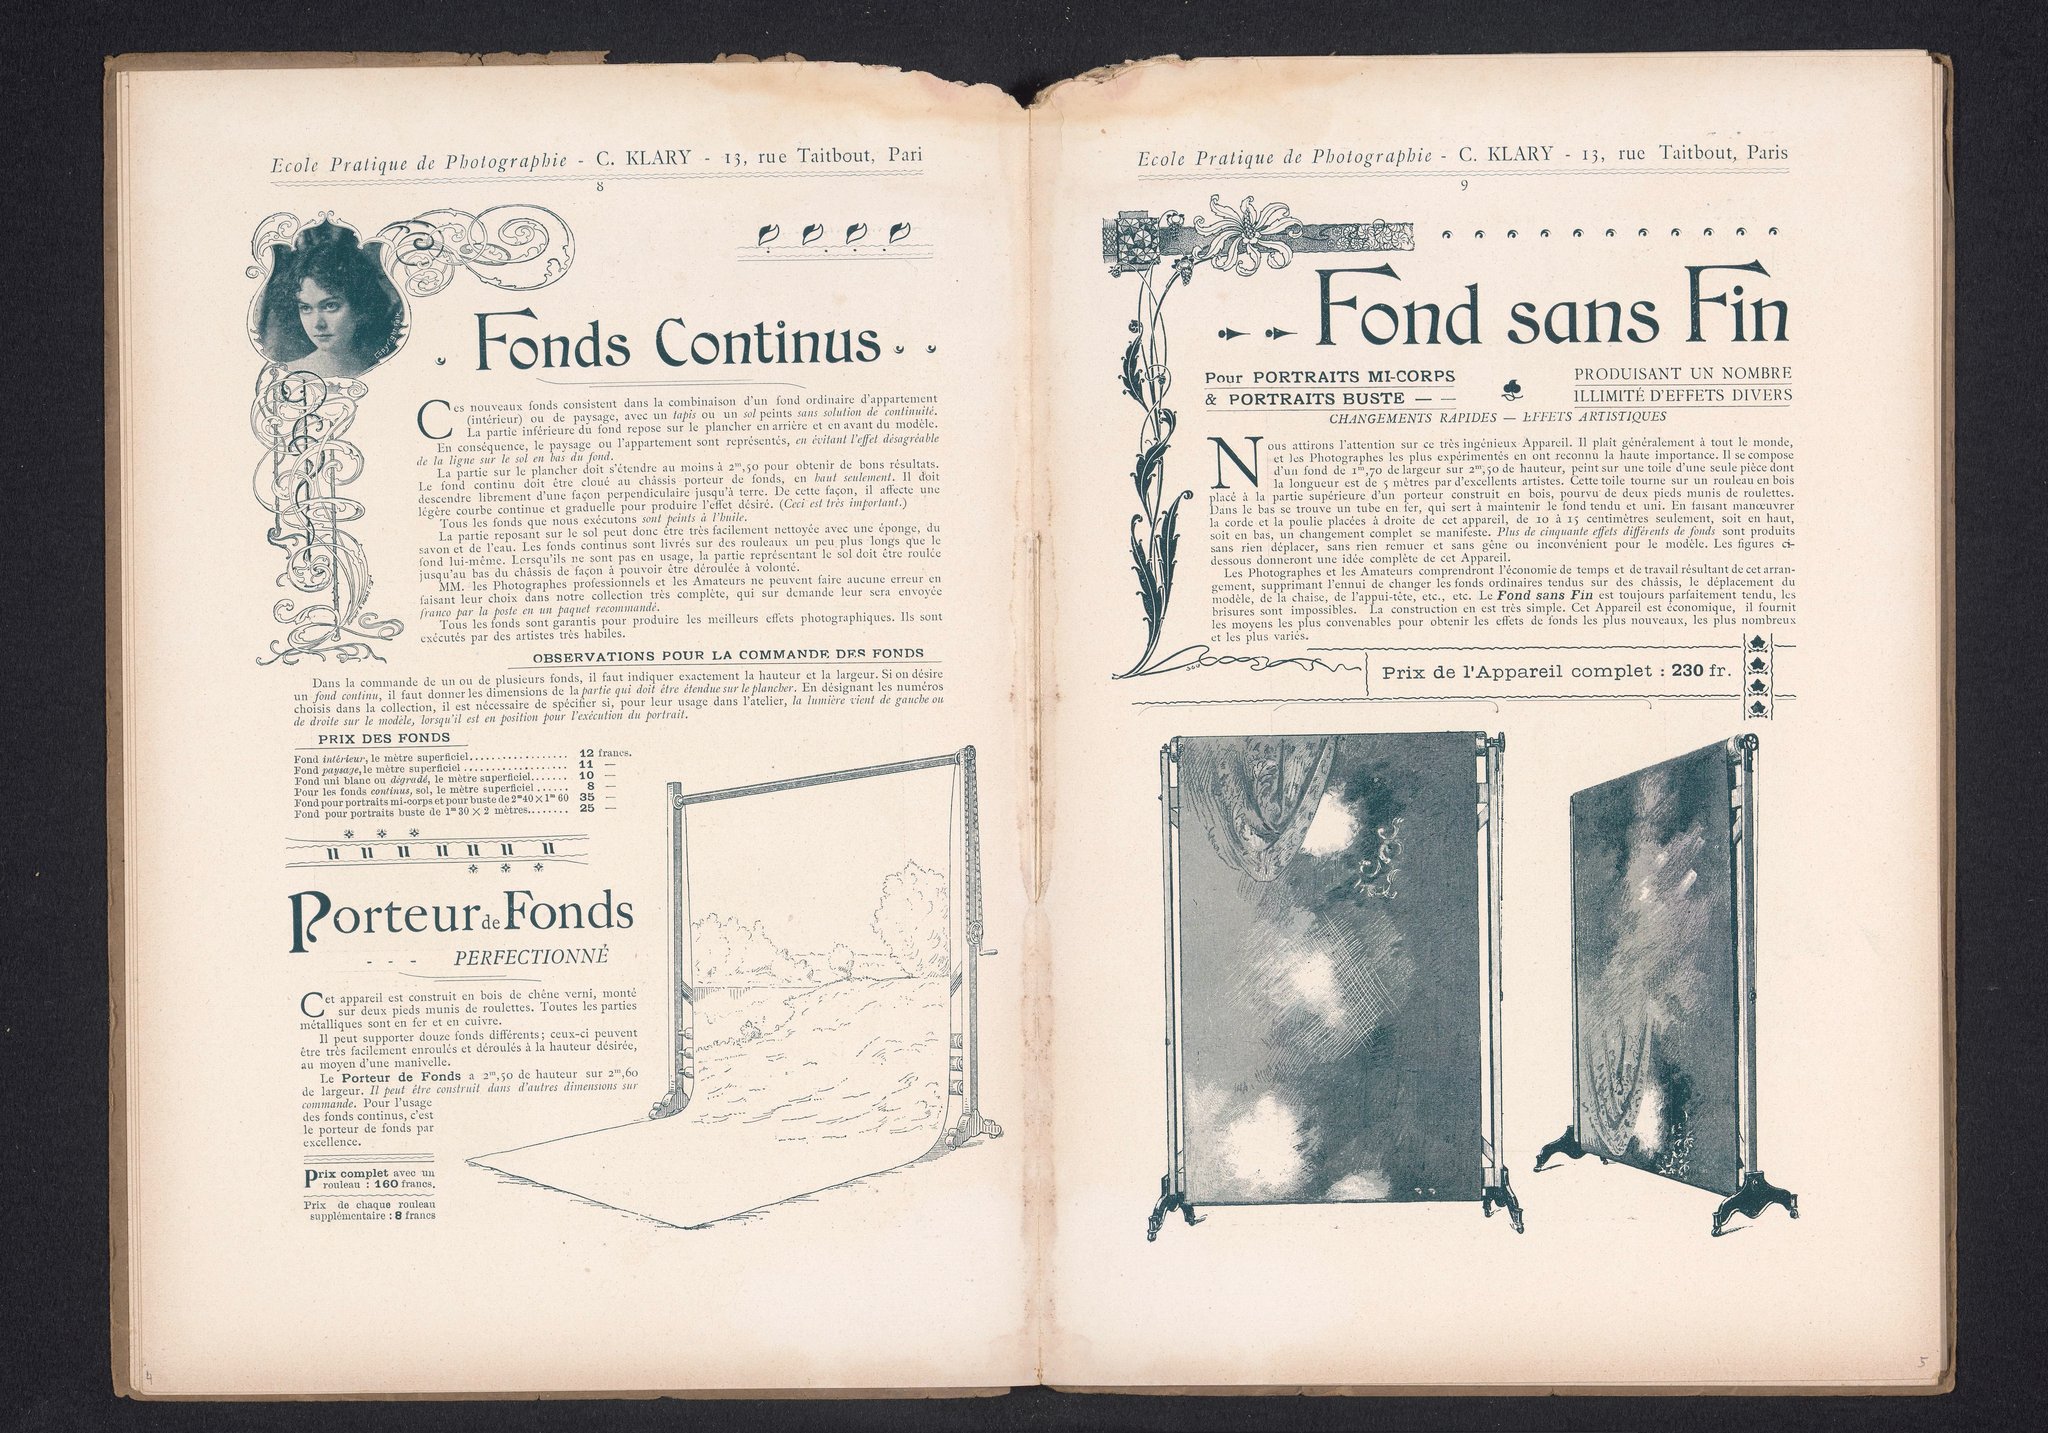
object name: page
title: Portret van een onbekende vrouw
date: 1890-1900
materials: paper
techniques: autotype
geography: paris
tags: adult woman